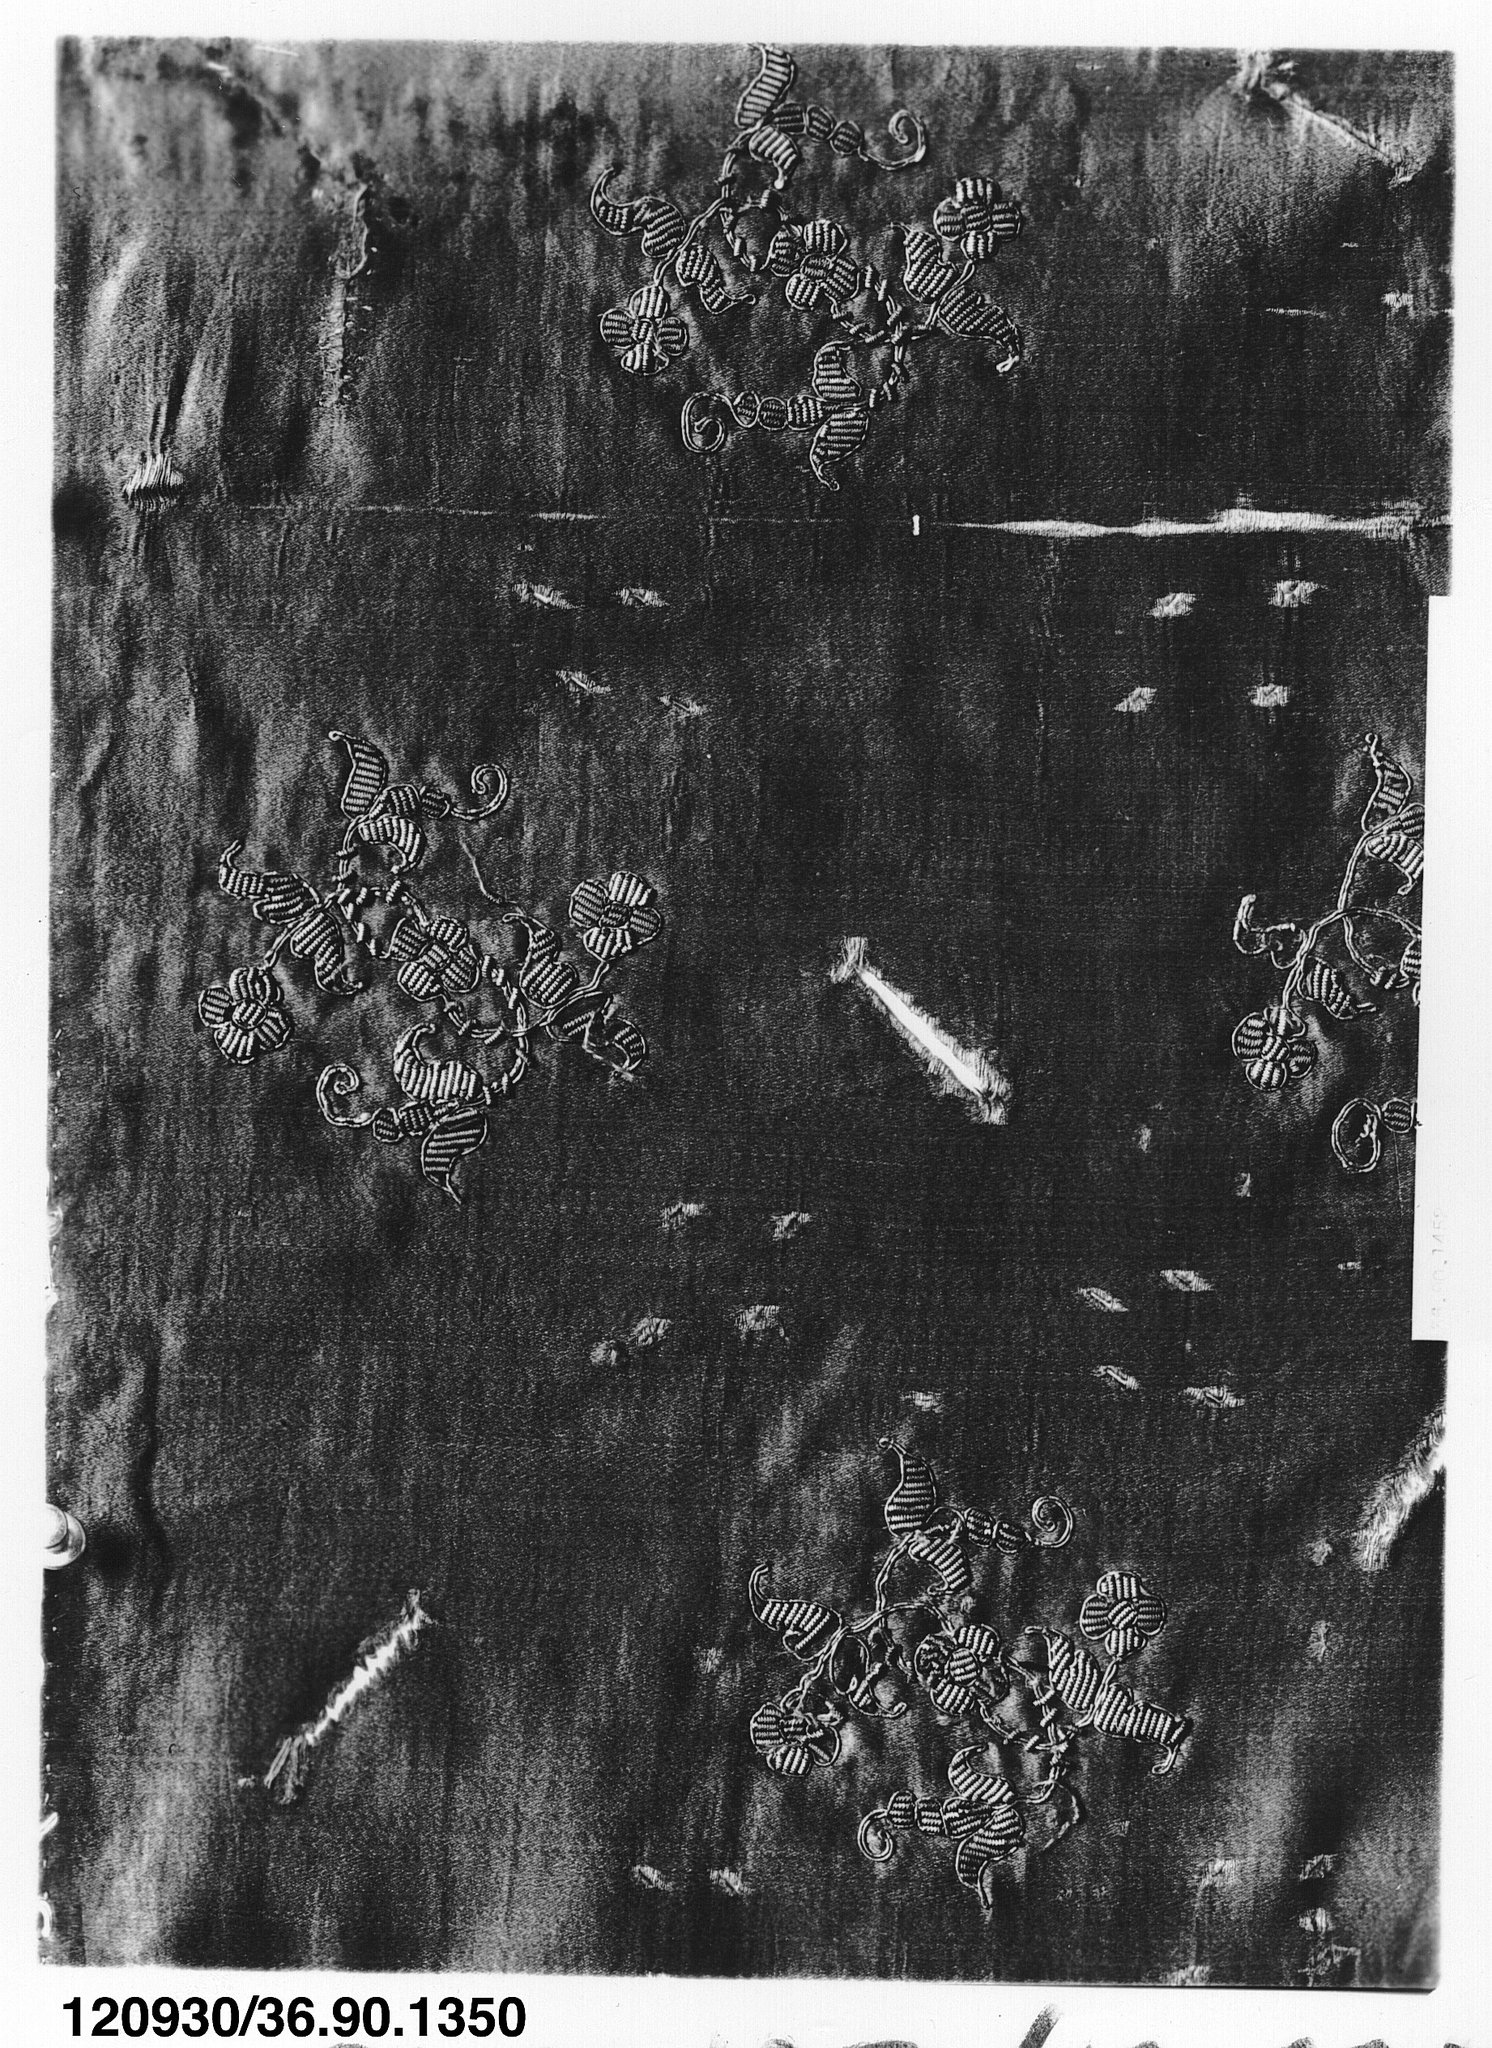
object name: piece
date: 1501-1700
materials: silk